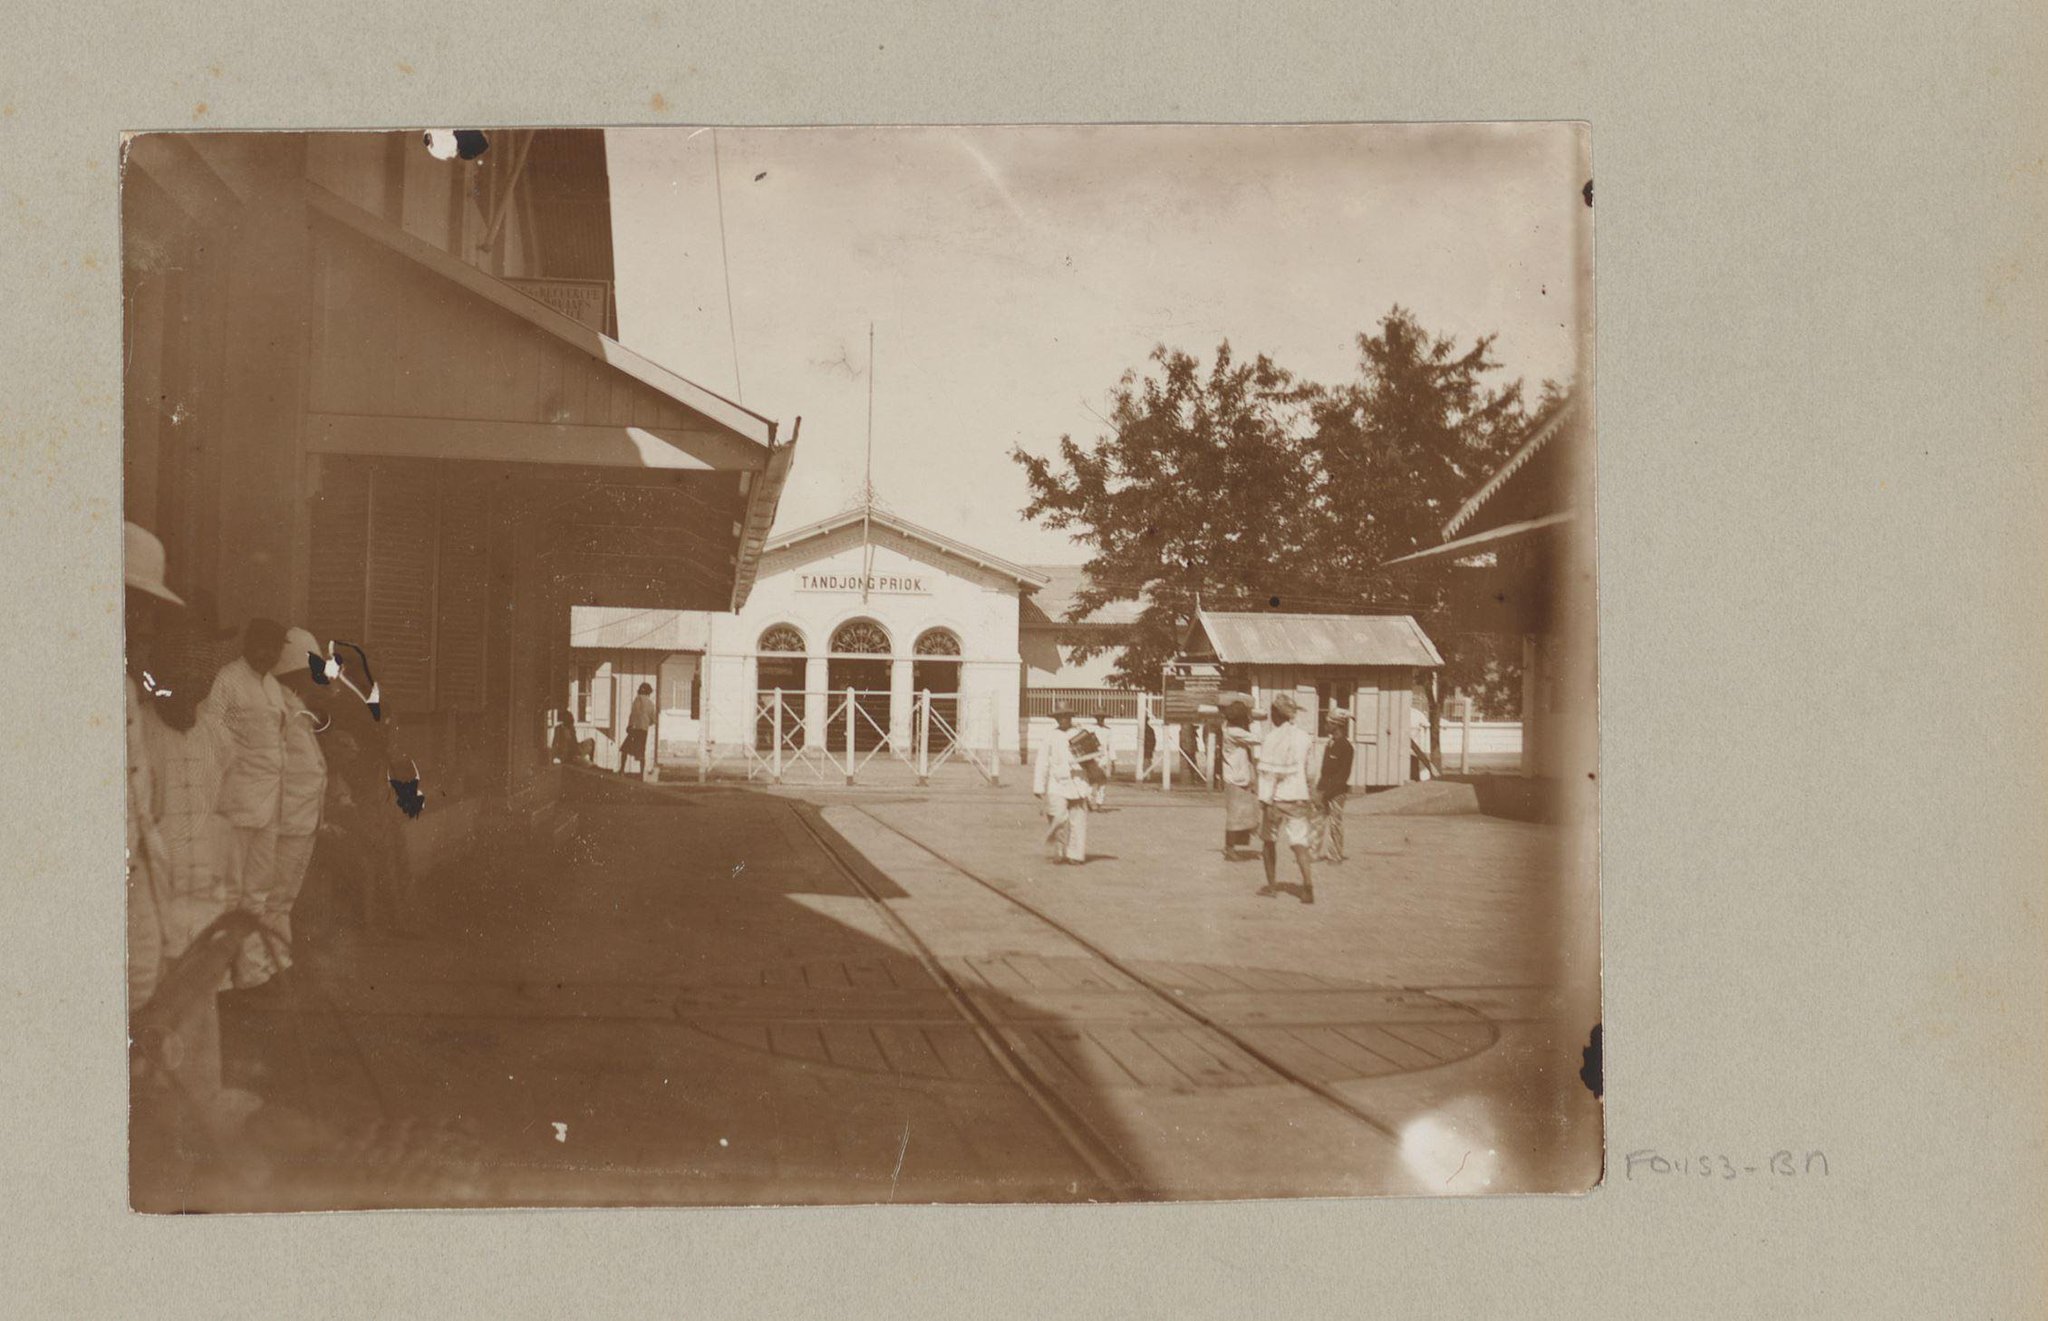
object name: album leaf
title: Straatgezicht te Tandjong Priok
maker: Anonymous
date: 1880-1900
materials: photographic support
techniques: collodion silver print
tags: village street, dutch east indies, the